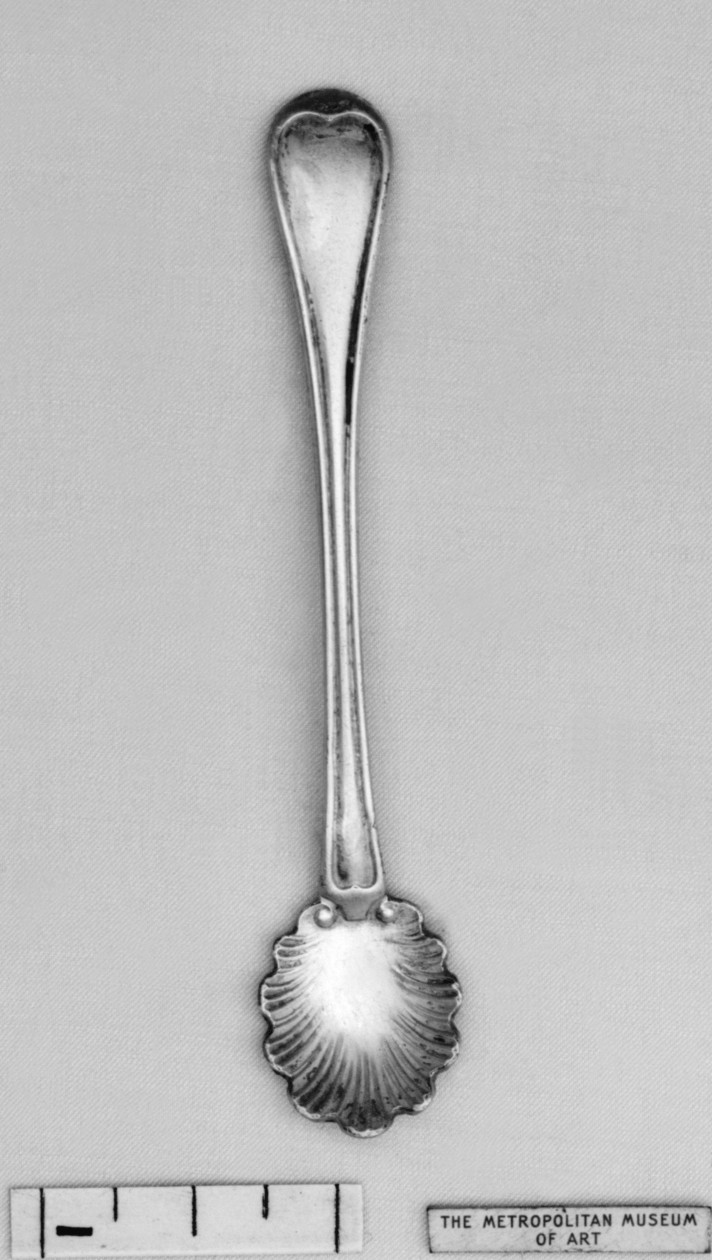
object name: salt spoon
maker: charles christofle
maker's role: maker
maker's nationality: french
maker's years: 1830-1930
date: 1851-1900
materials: gilt, silver